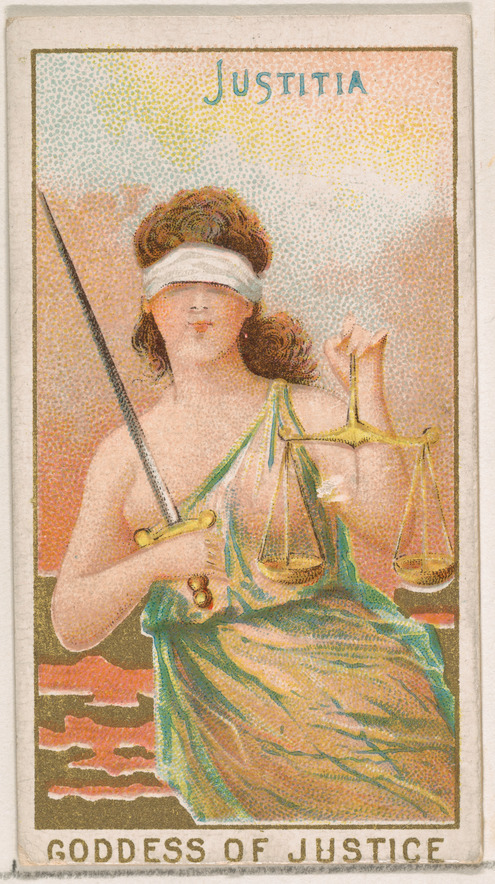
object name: print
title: Justitia, Goddess of Justice, from the Goddesses of the Greeks and Romans series (N188) issued by Wm. S. Kimball & Co.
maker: william s. kimball & company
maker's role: publisher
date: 1889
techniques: color lithograph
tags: goddess